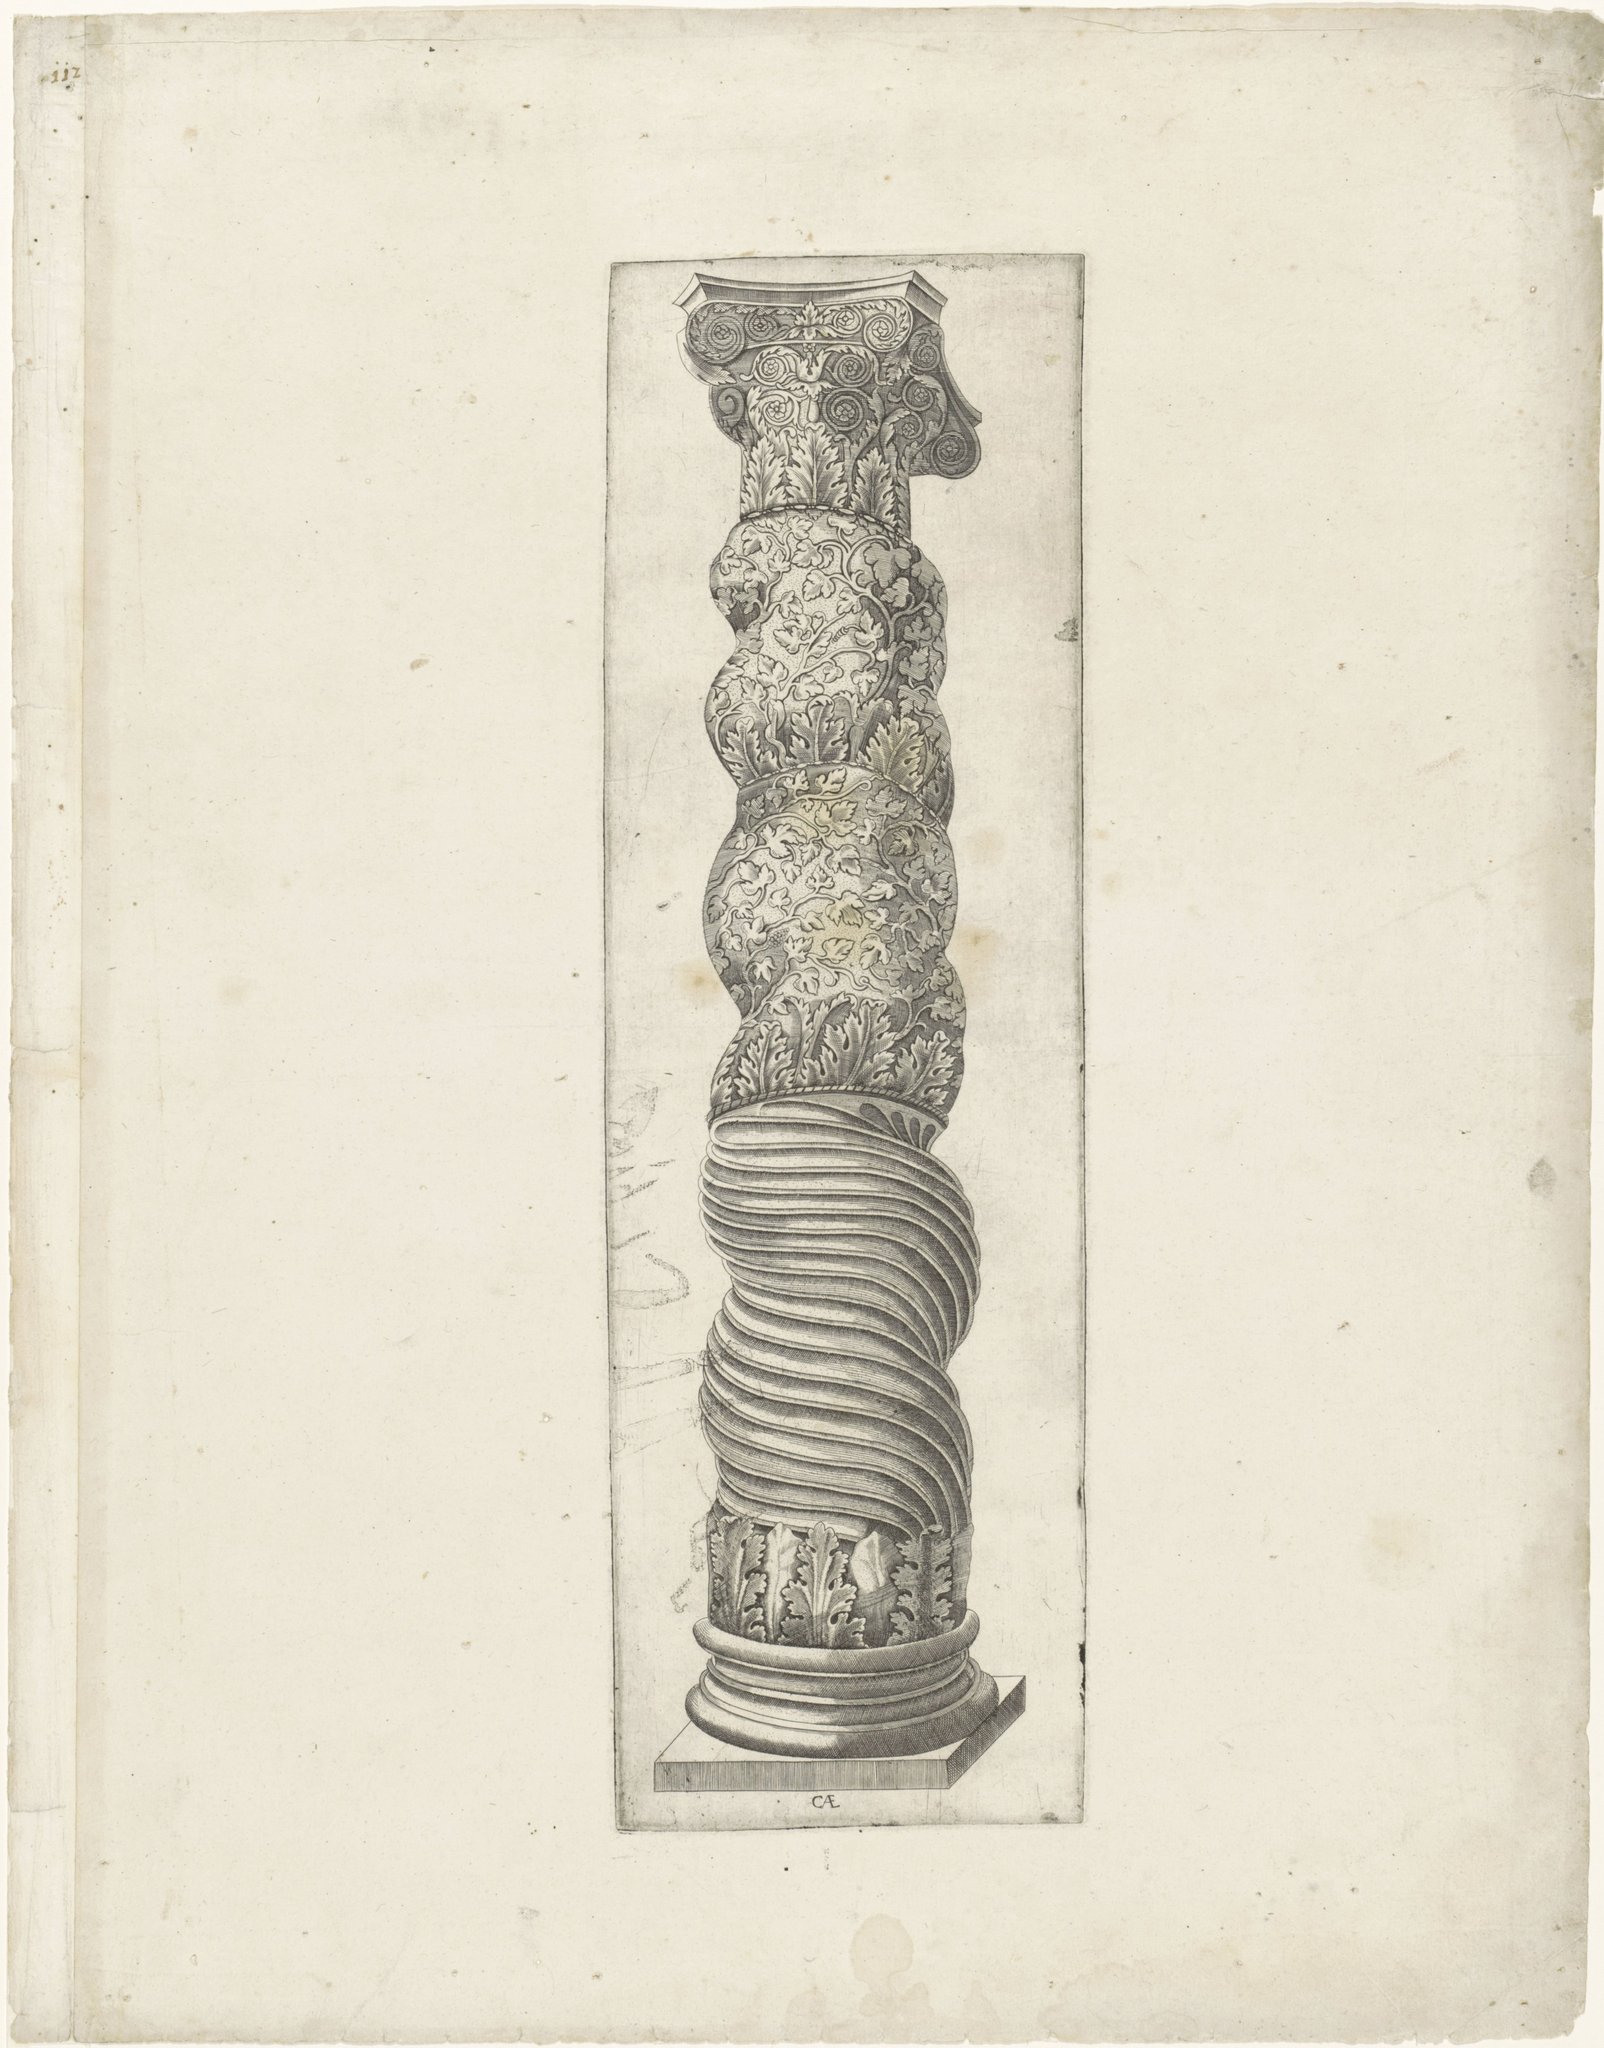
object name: print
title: Getordeerde zuil uit de St. Pieter (Colonna Santa)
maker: monogrammist cae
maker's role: print maker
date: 1550-1570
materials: paper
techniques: engraving, etching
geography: italy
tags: spiral or solomonic column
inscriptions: collector's mark: Lugt 2228, watermark, watermark, collector's mark: Lugt 2760, number: ‘112’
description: Folio 112 uit het prentalbum van Johann Georg I. Zobel von Giebelstadt (Röttingen 1543-07-20 - Bamberg 1580-09-07), de latere bisschop van Bamberg. Het album is vermoedelijk samengesteld tussen 1568 en 1570 in Venetië. Het album werd in 1999 uit elkaar genomen door een antiquair. De in totaal 124 folio's met prenten uit het "Zobel Album" werden aangekocht door verschillende musea en privéverzamelingen. De grootste groep (68 folio's) bevindt zich in de collectie van het Rijksmuseum. Spiegelbeeldige kopie naar prent van Nicolas Beatrizet (RP-P-2005-319).